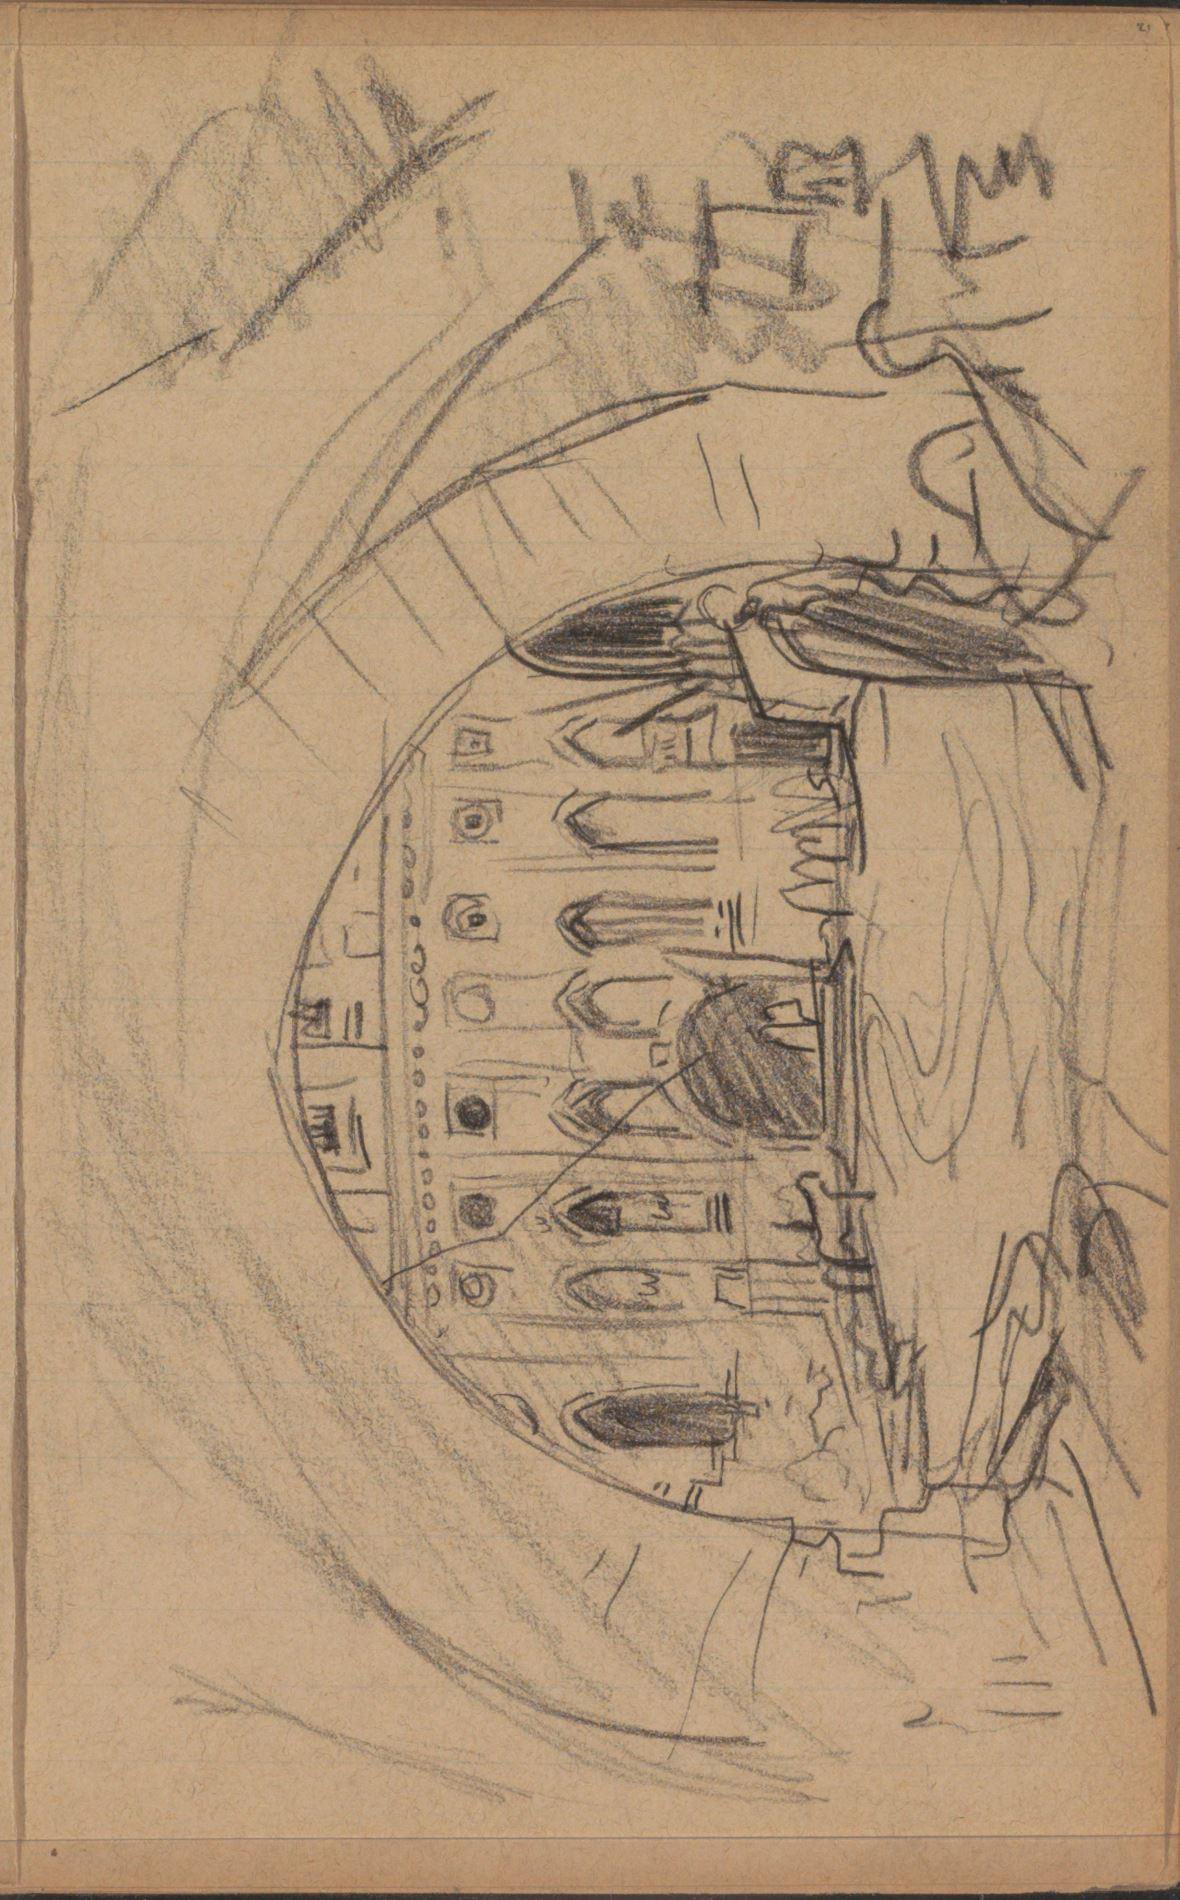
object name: sketchbook leaf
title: Figuur bij een poort naar een binnenplaats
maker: marius bauer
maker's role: draughtsman, print maker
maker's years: 1867-1932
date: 1896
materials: chalk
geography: russia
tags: standing figure, arch, archivolt ~ architecture, courtyard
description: Pagina 21 uit een schetsboek met 50 bladen.